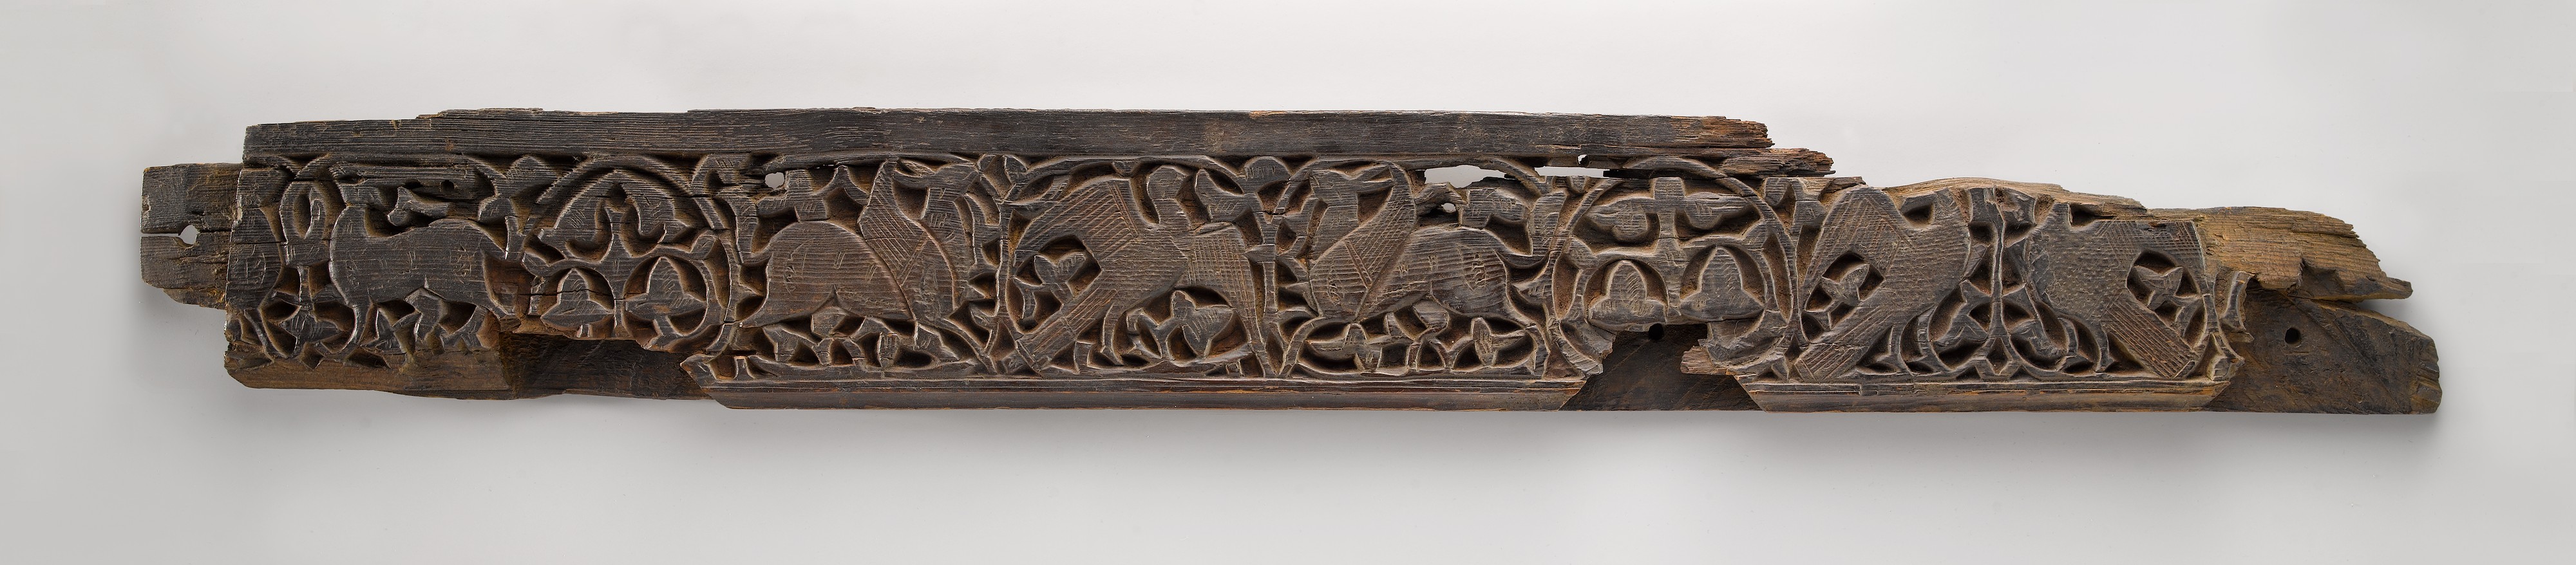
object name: panel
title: Panel with Birds, Griffins, and Animals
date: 1001-1200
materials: wood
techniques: carving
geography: egypt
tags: animals,birds,griffins